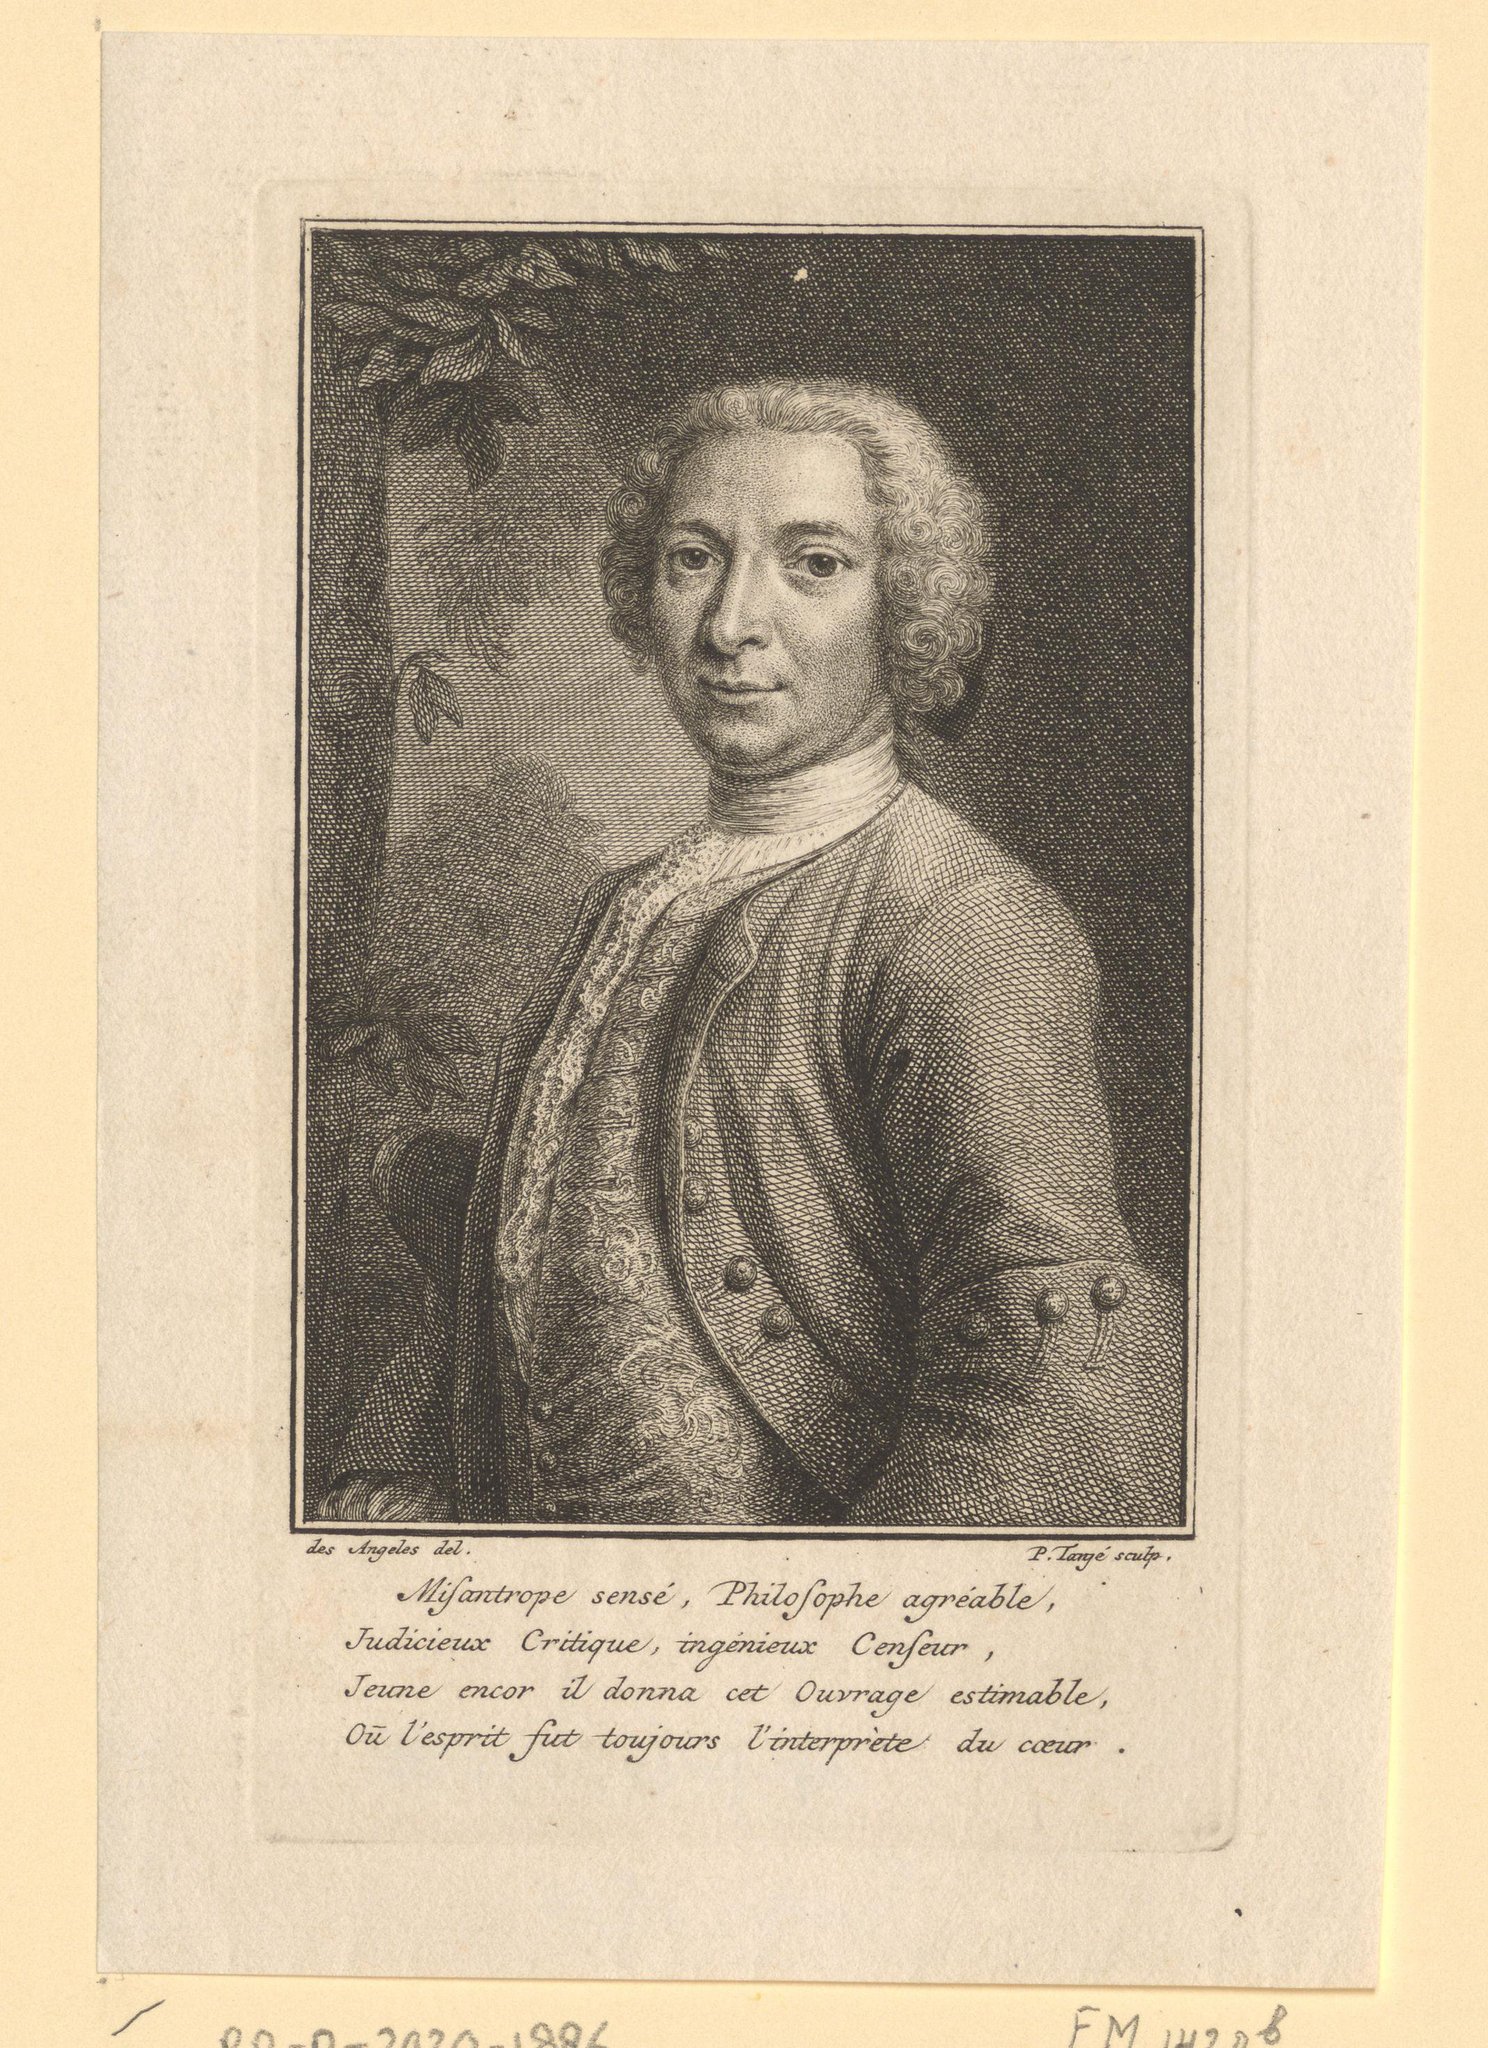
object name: print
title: Portret van Justus van Effen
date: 1716-1761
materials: paper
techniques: etching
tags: utrecht, den bosch, historical persons, portrait of a writer